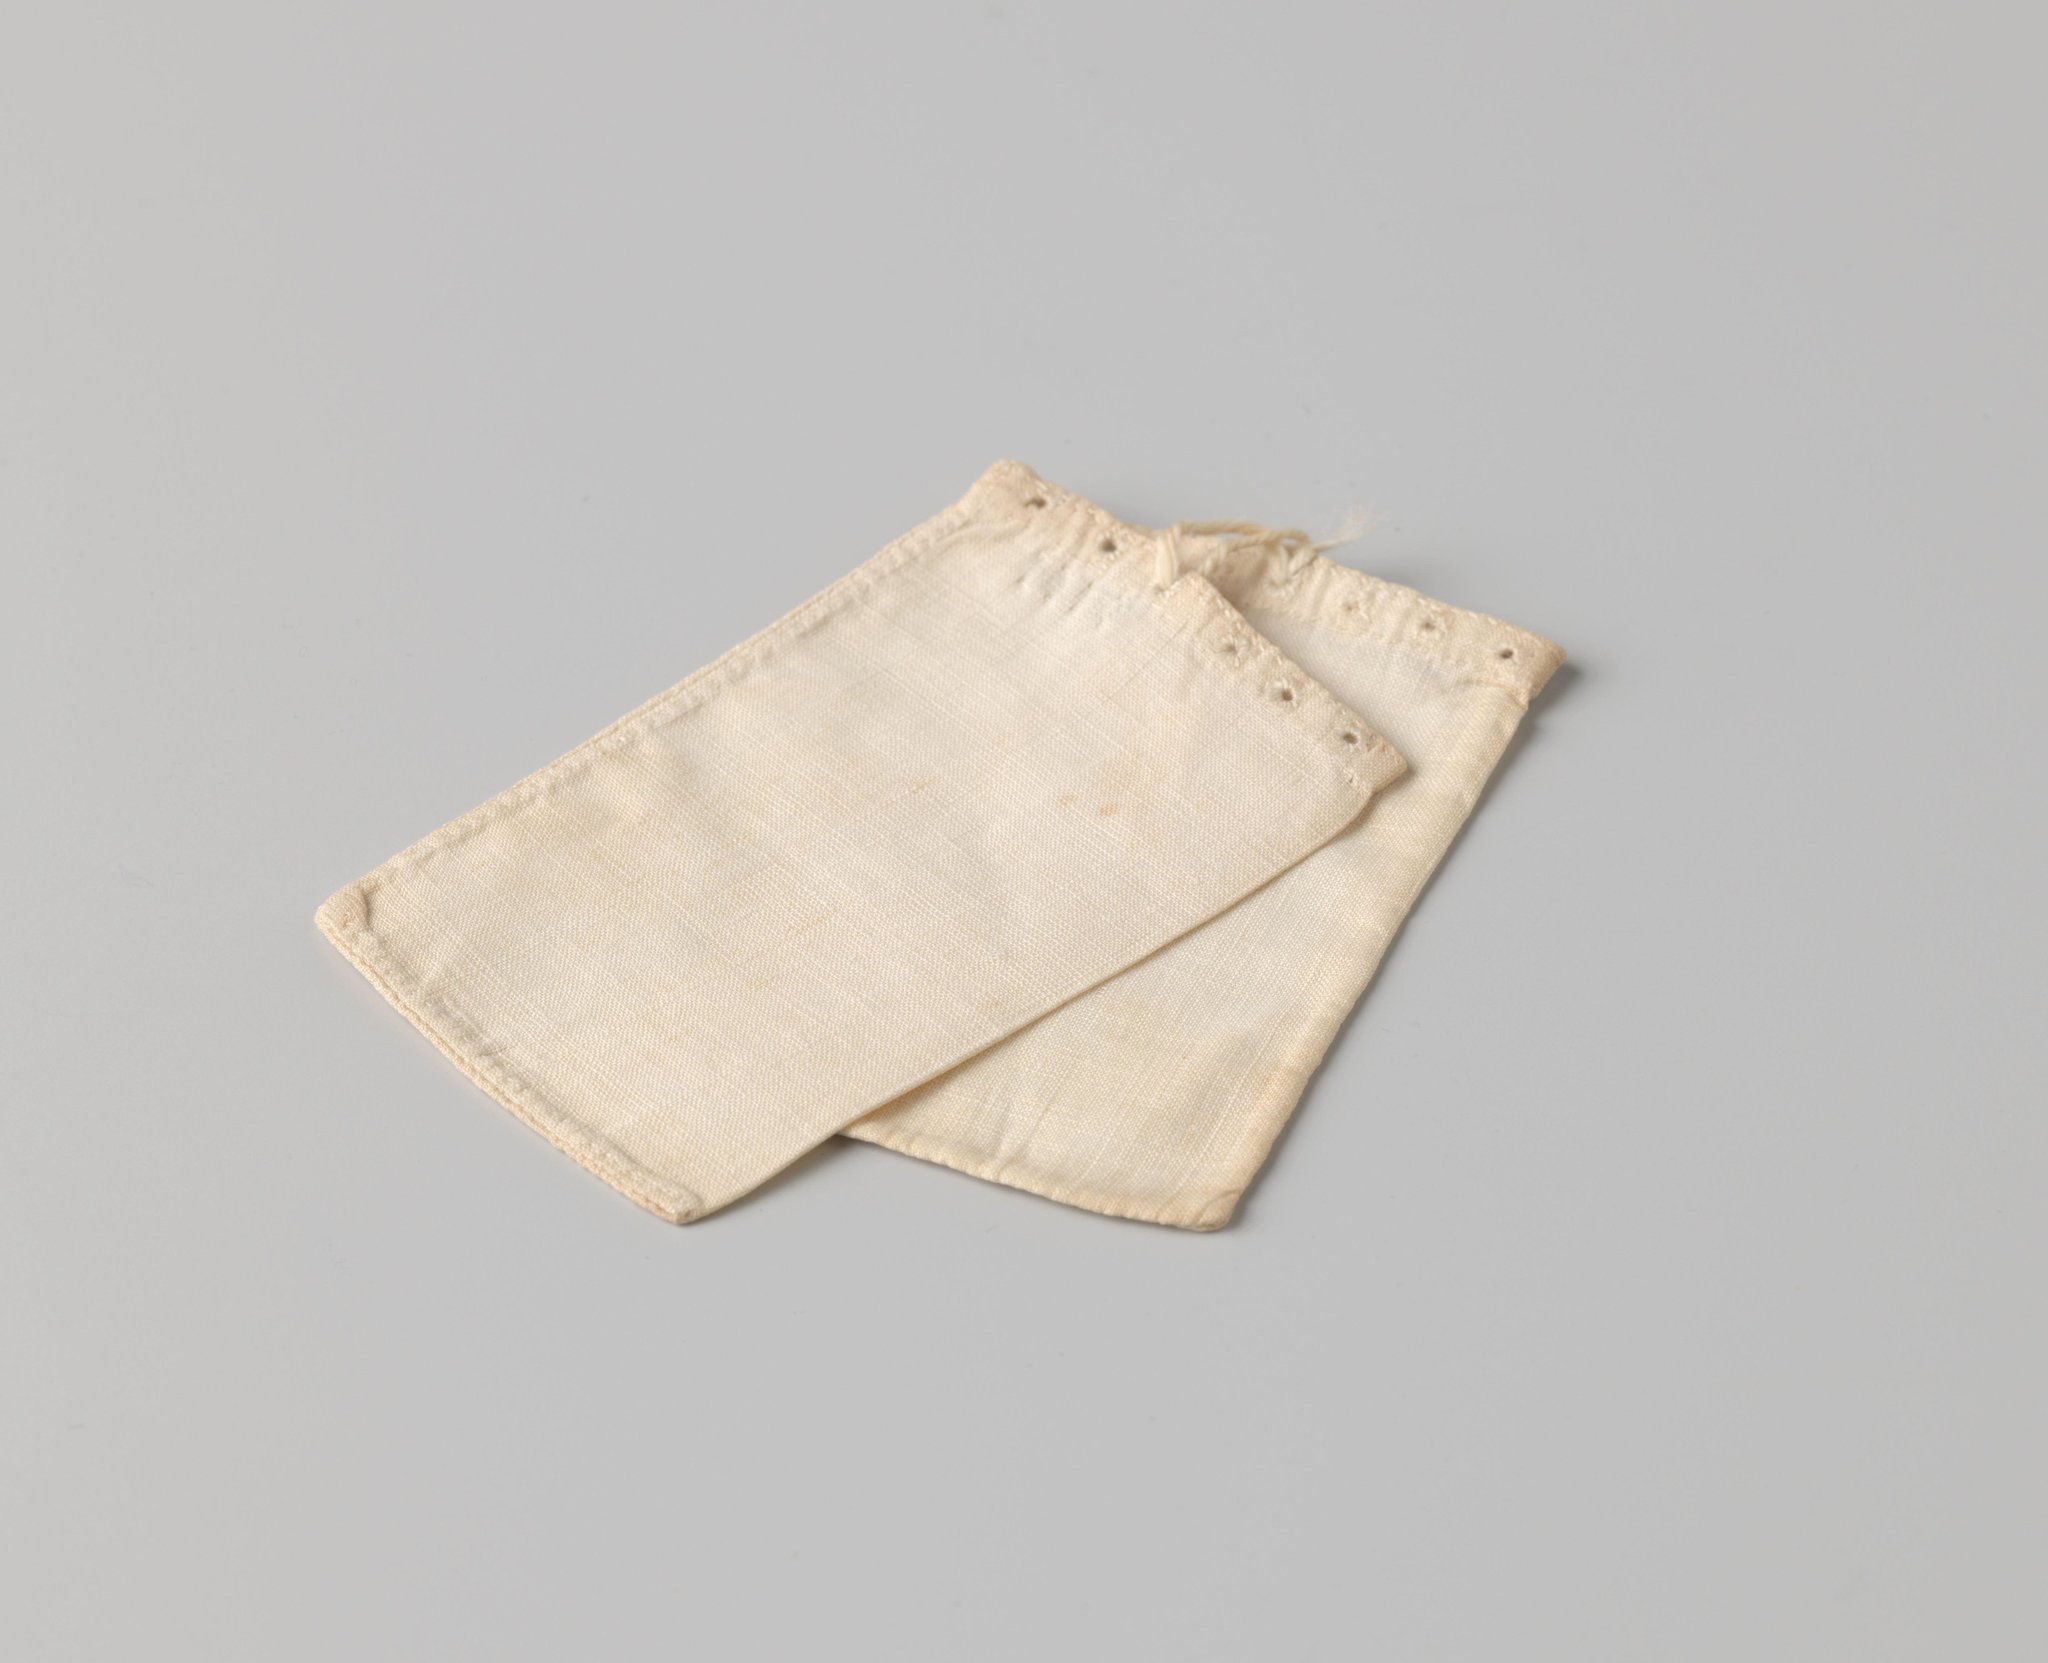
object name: miniature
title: Sloop met koordsluiting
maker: Anonymous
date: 1750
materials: linen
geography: netherlands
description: Sloop voor kussen, aan korte zijde voorzien van zes gaten voor koordsluiting.